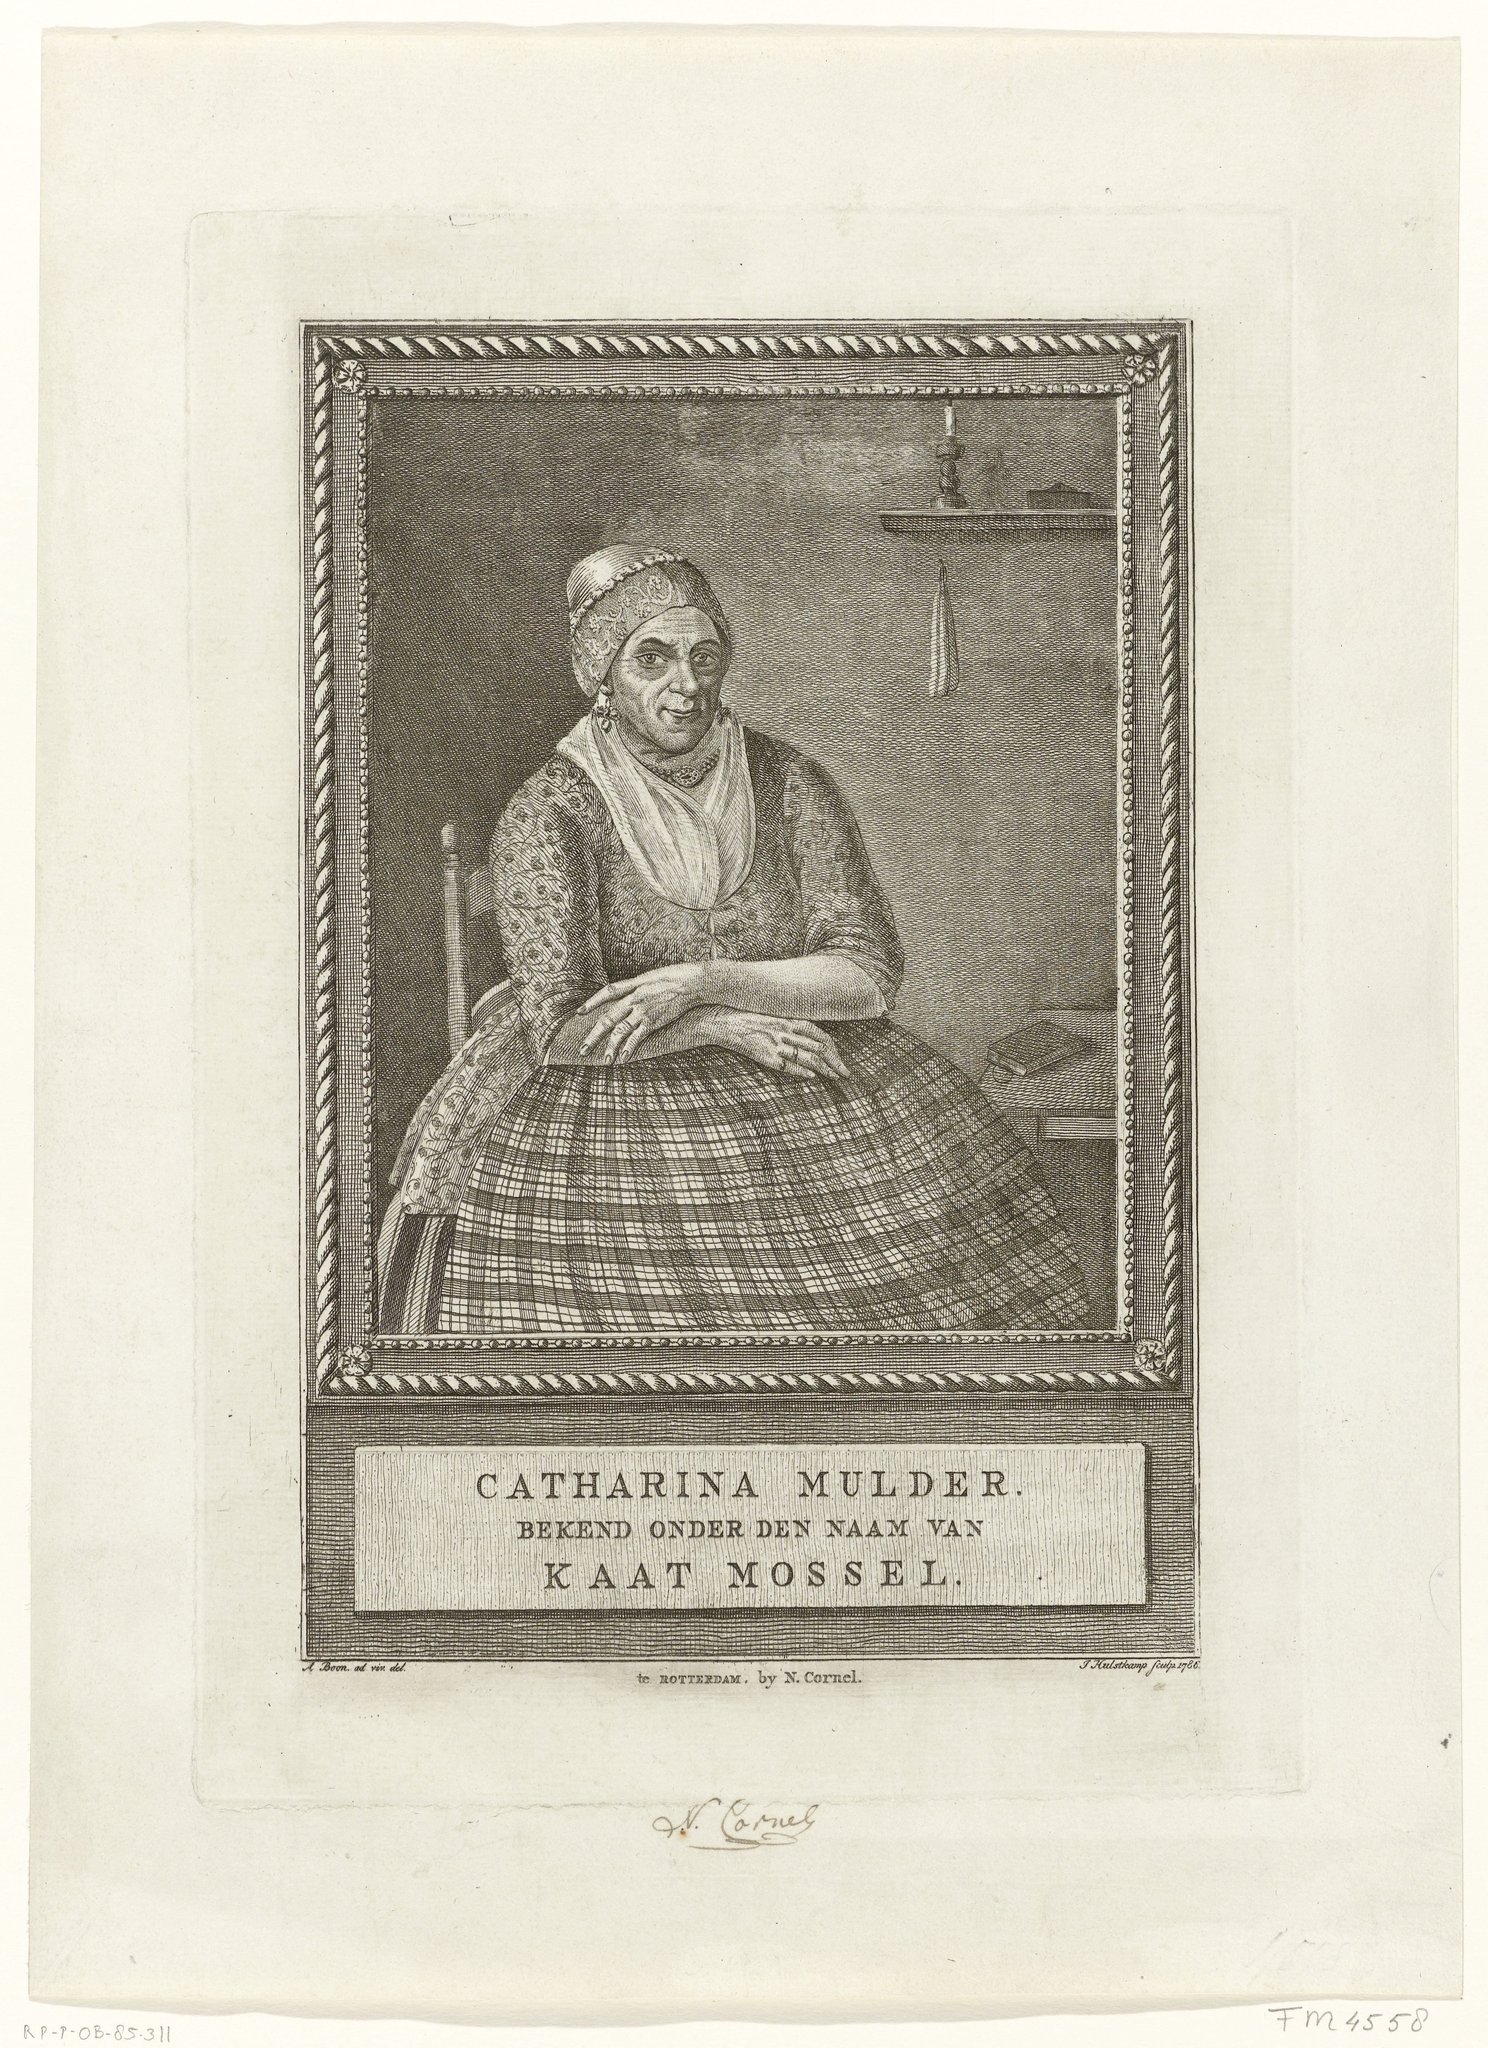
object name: print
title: Portret van Kaat Mossel, 1784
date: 1786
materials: paper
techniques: engraving, etching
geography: rotterdam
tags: kaat mossel, rotterdam, patriots (1780-1795)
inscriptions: collector's mark: Lugt 2228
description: Het is onduidelijk waarom Van der Kellen in het Supplement de vervaardiging van deze prent toeschrift aan T. de Roode ipv Hulstkamp.